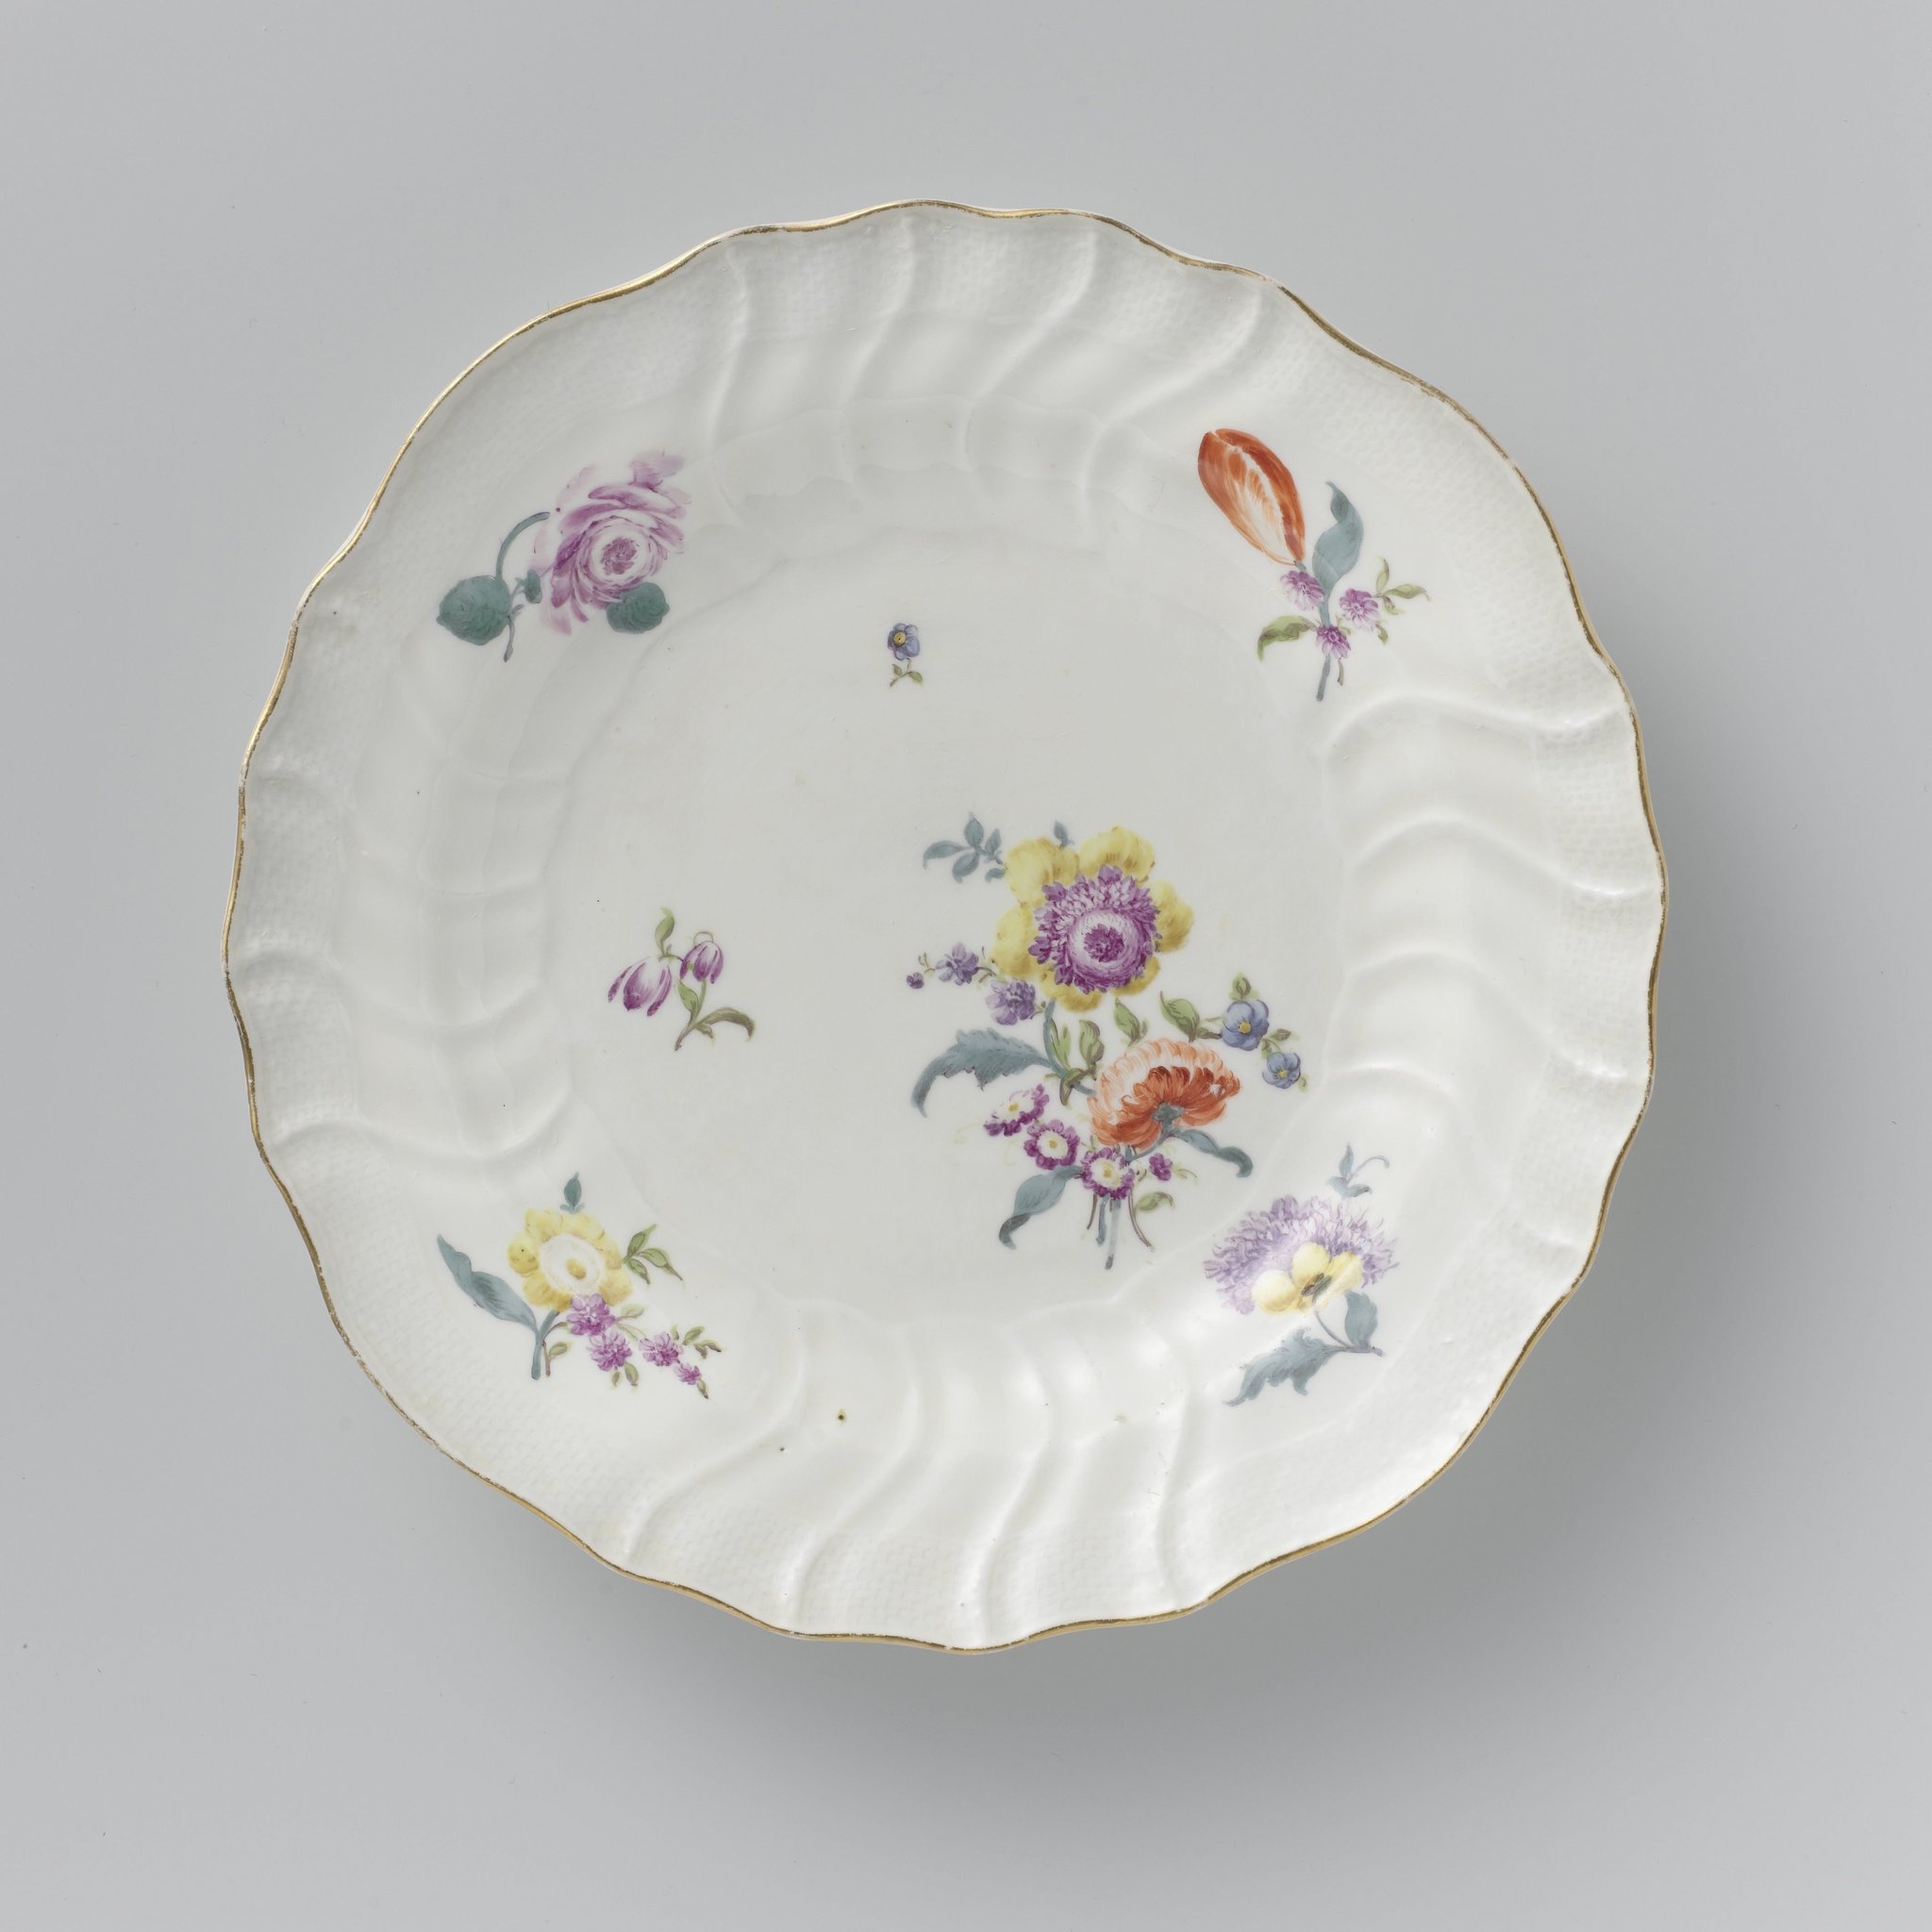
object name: eating drinking utensil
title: Bord, veelkleurig beschilderd met Deutsche Blumen, insekten en vruchten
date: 1750-1760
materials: porcelain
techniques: painted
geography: meissen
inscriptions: factory mark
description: Rond bord van beschilderd porselein. Het bord is beschilderd met Deutsche Blumen, insekten en vruchten. De rand is in reliëf versierd met het Neuozier-patroon. Het bord is gemerkt en hoort bij een servies (BK-17474-1 t/m BK-17474-253).